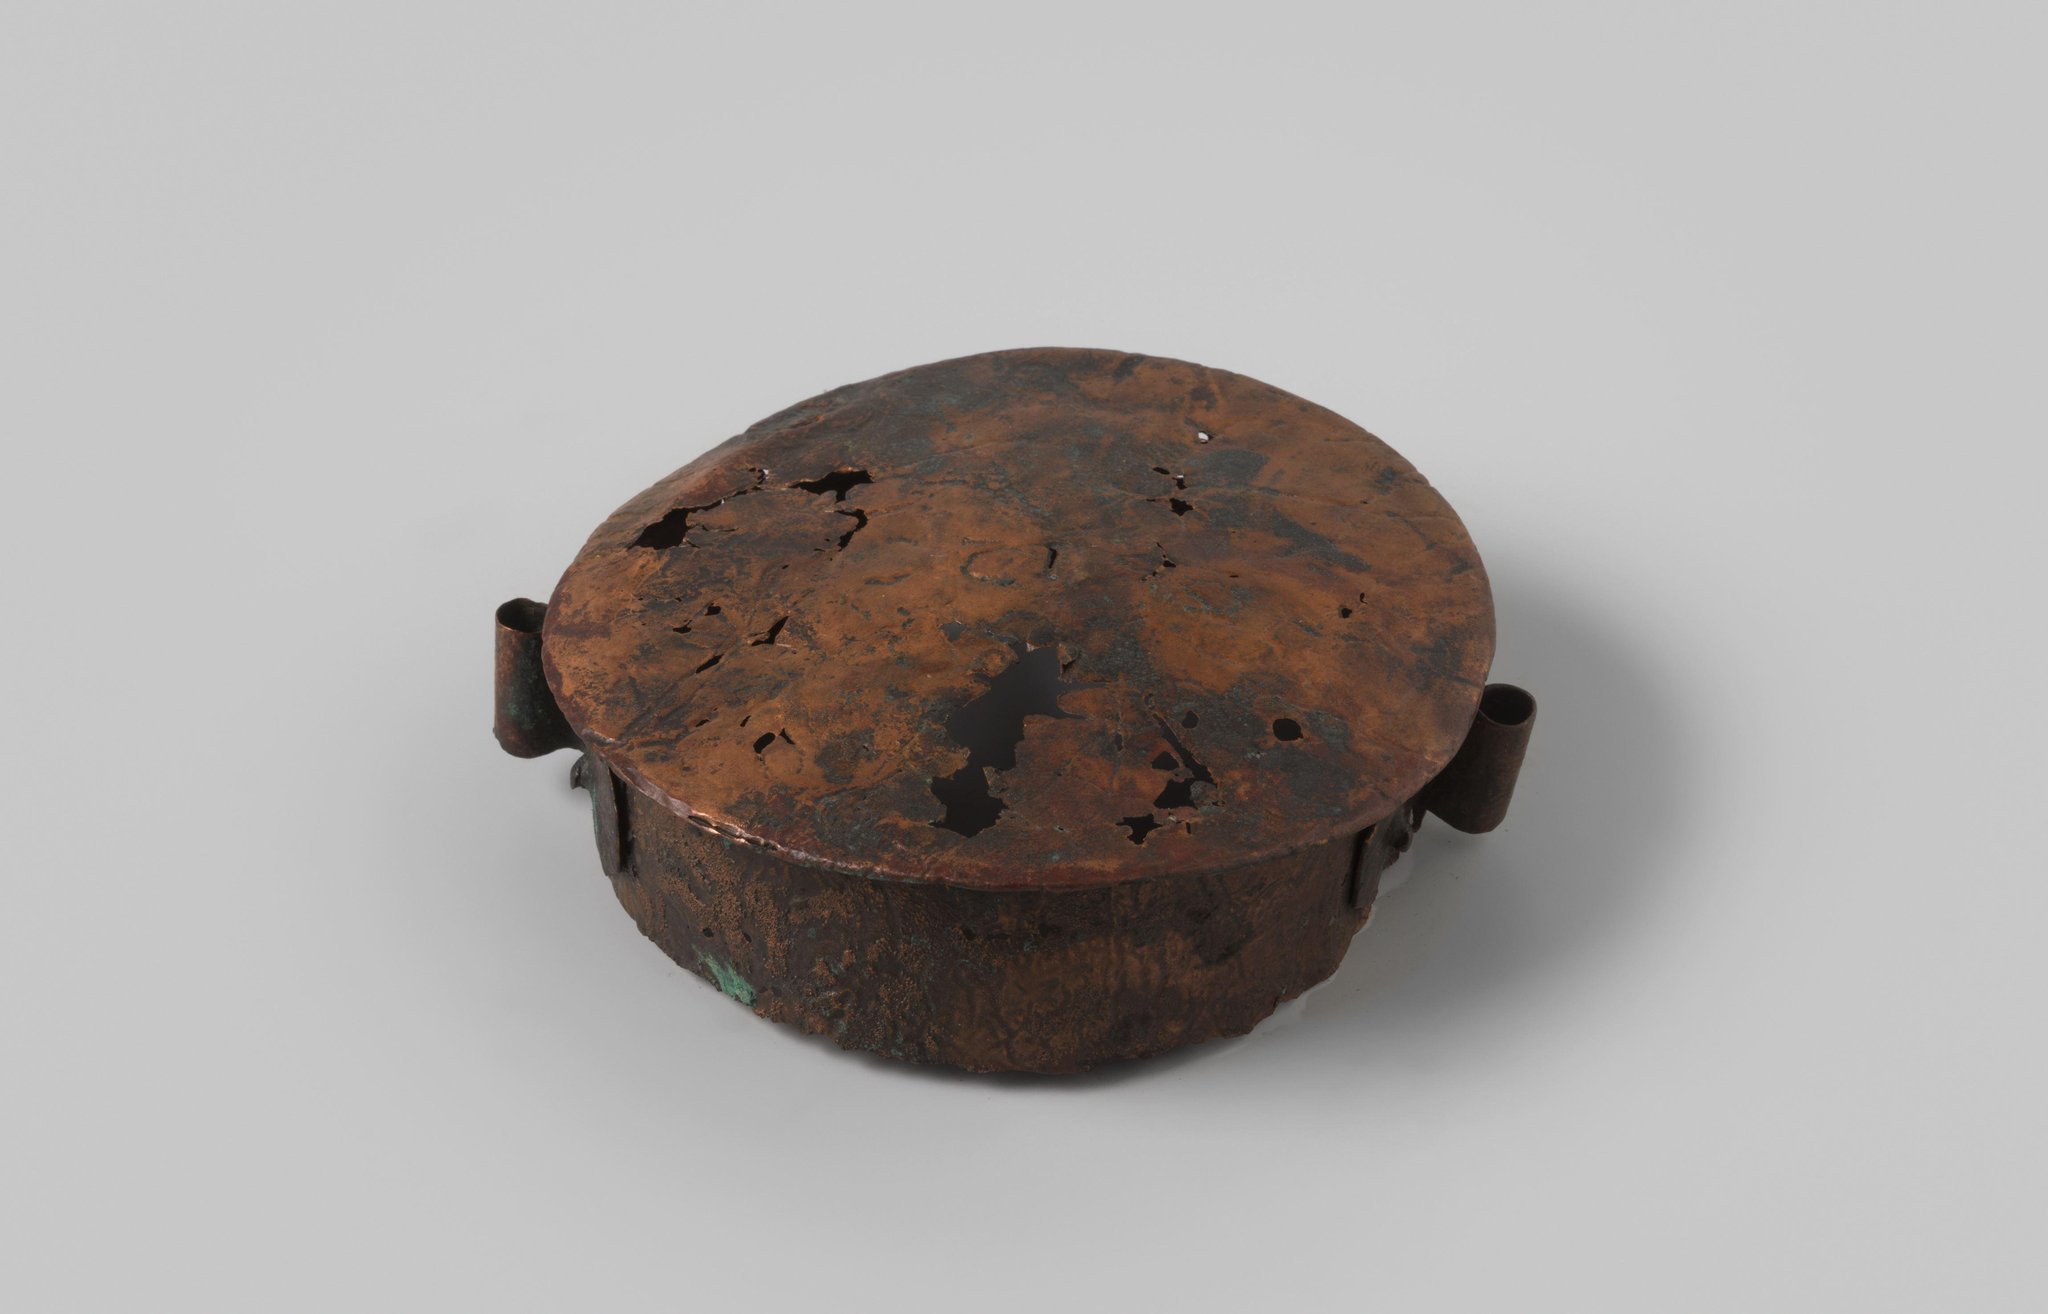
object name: lid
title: Deksel van een kruitbus uit het wrak van de Oost-Indiëvaarder Hollandia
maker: Anonymous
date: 1700-1743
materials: copper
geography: netherlands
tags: verenigde oostindische compagnie, hollandia (schip), annet